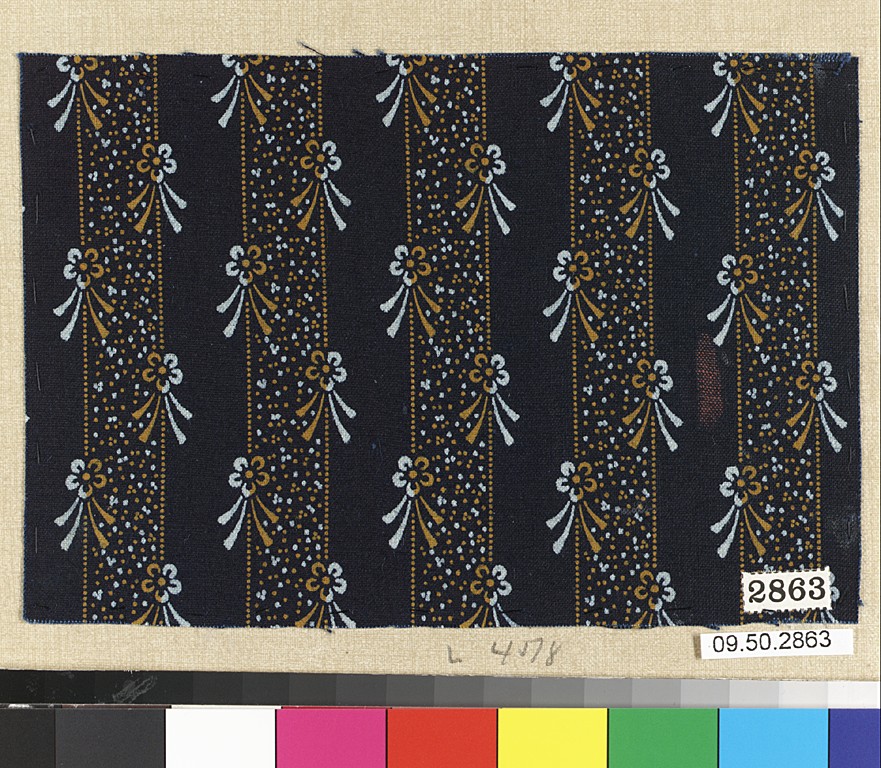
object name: piece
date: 1801-1900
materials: cotton